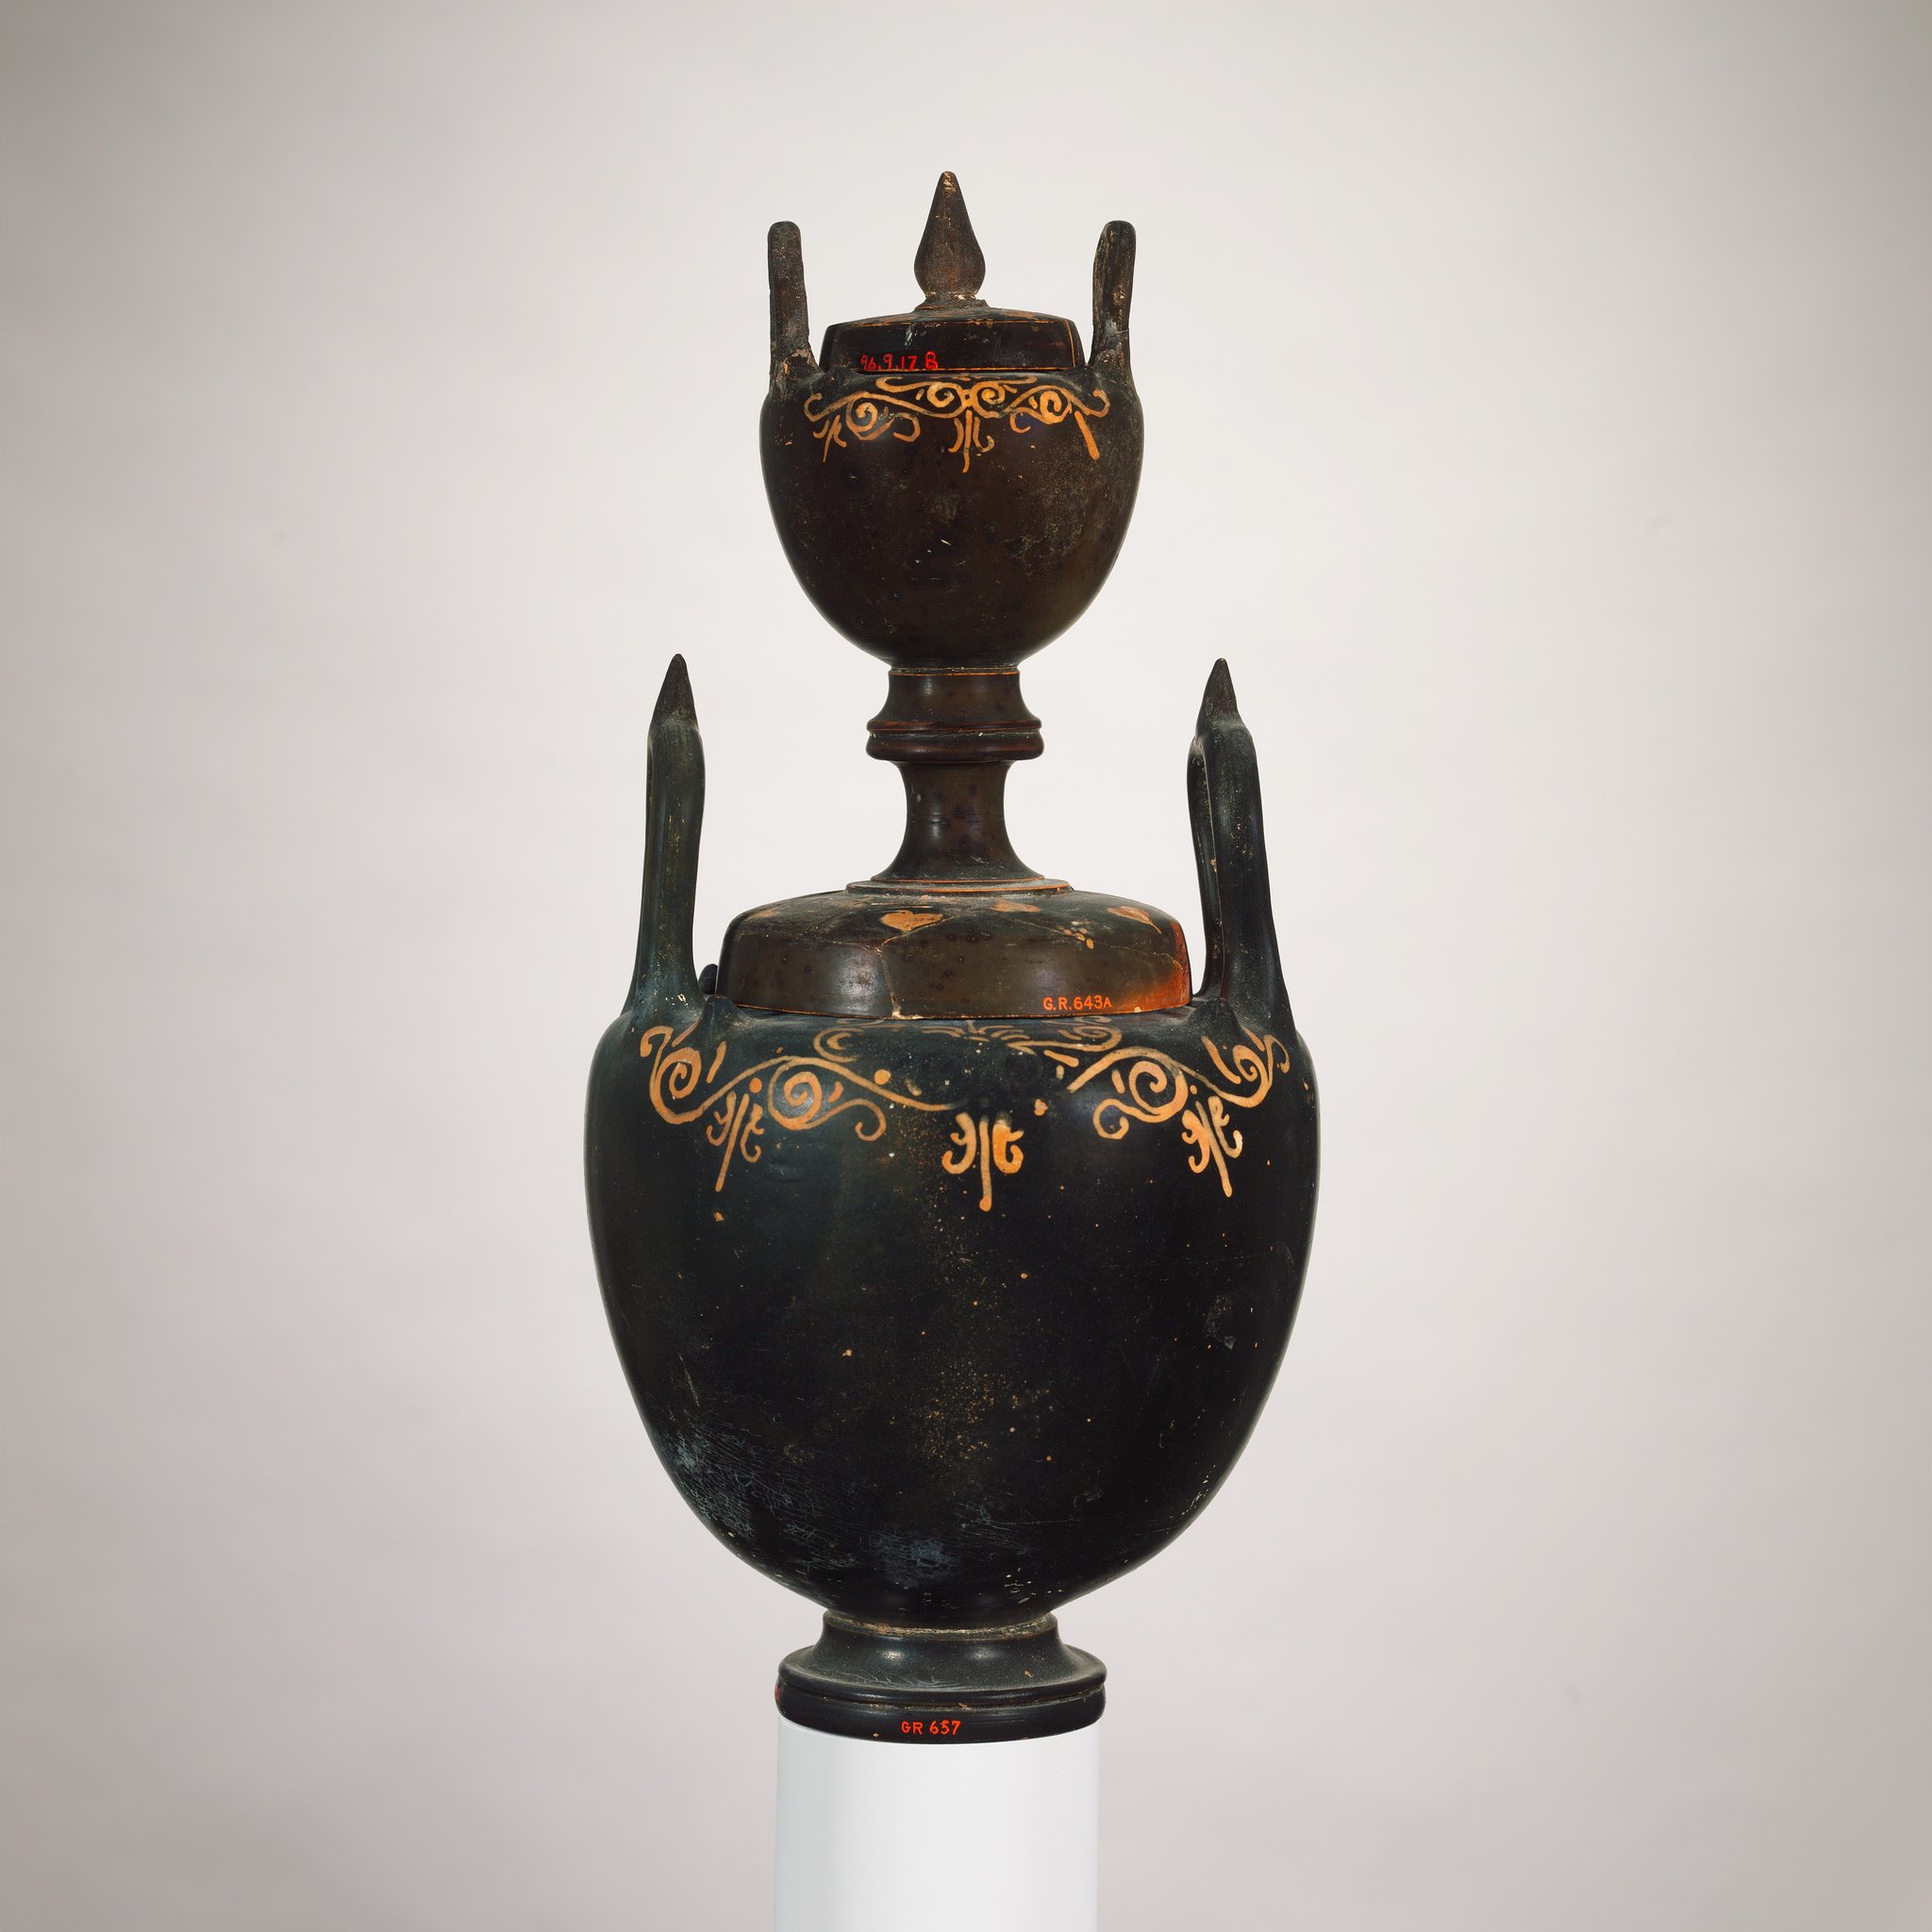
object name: lebes gamikos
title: Lebes gamikos (jar associated with weddings)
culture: greek, south italian, apulian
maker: xenon group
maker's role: artist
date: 400-301 BCE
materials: terracotta